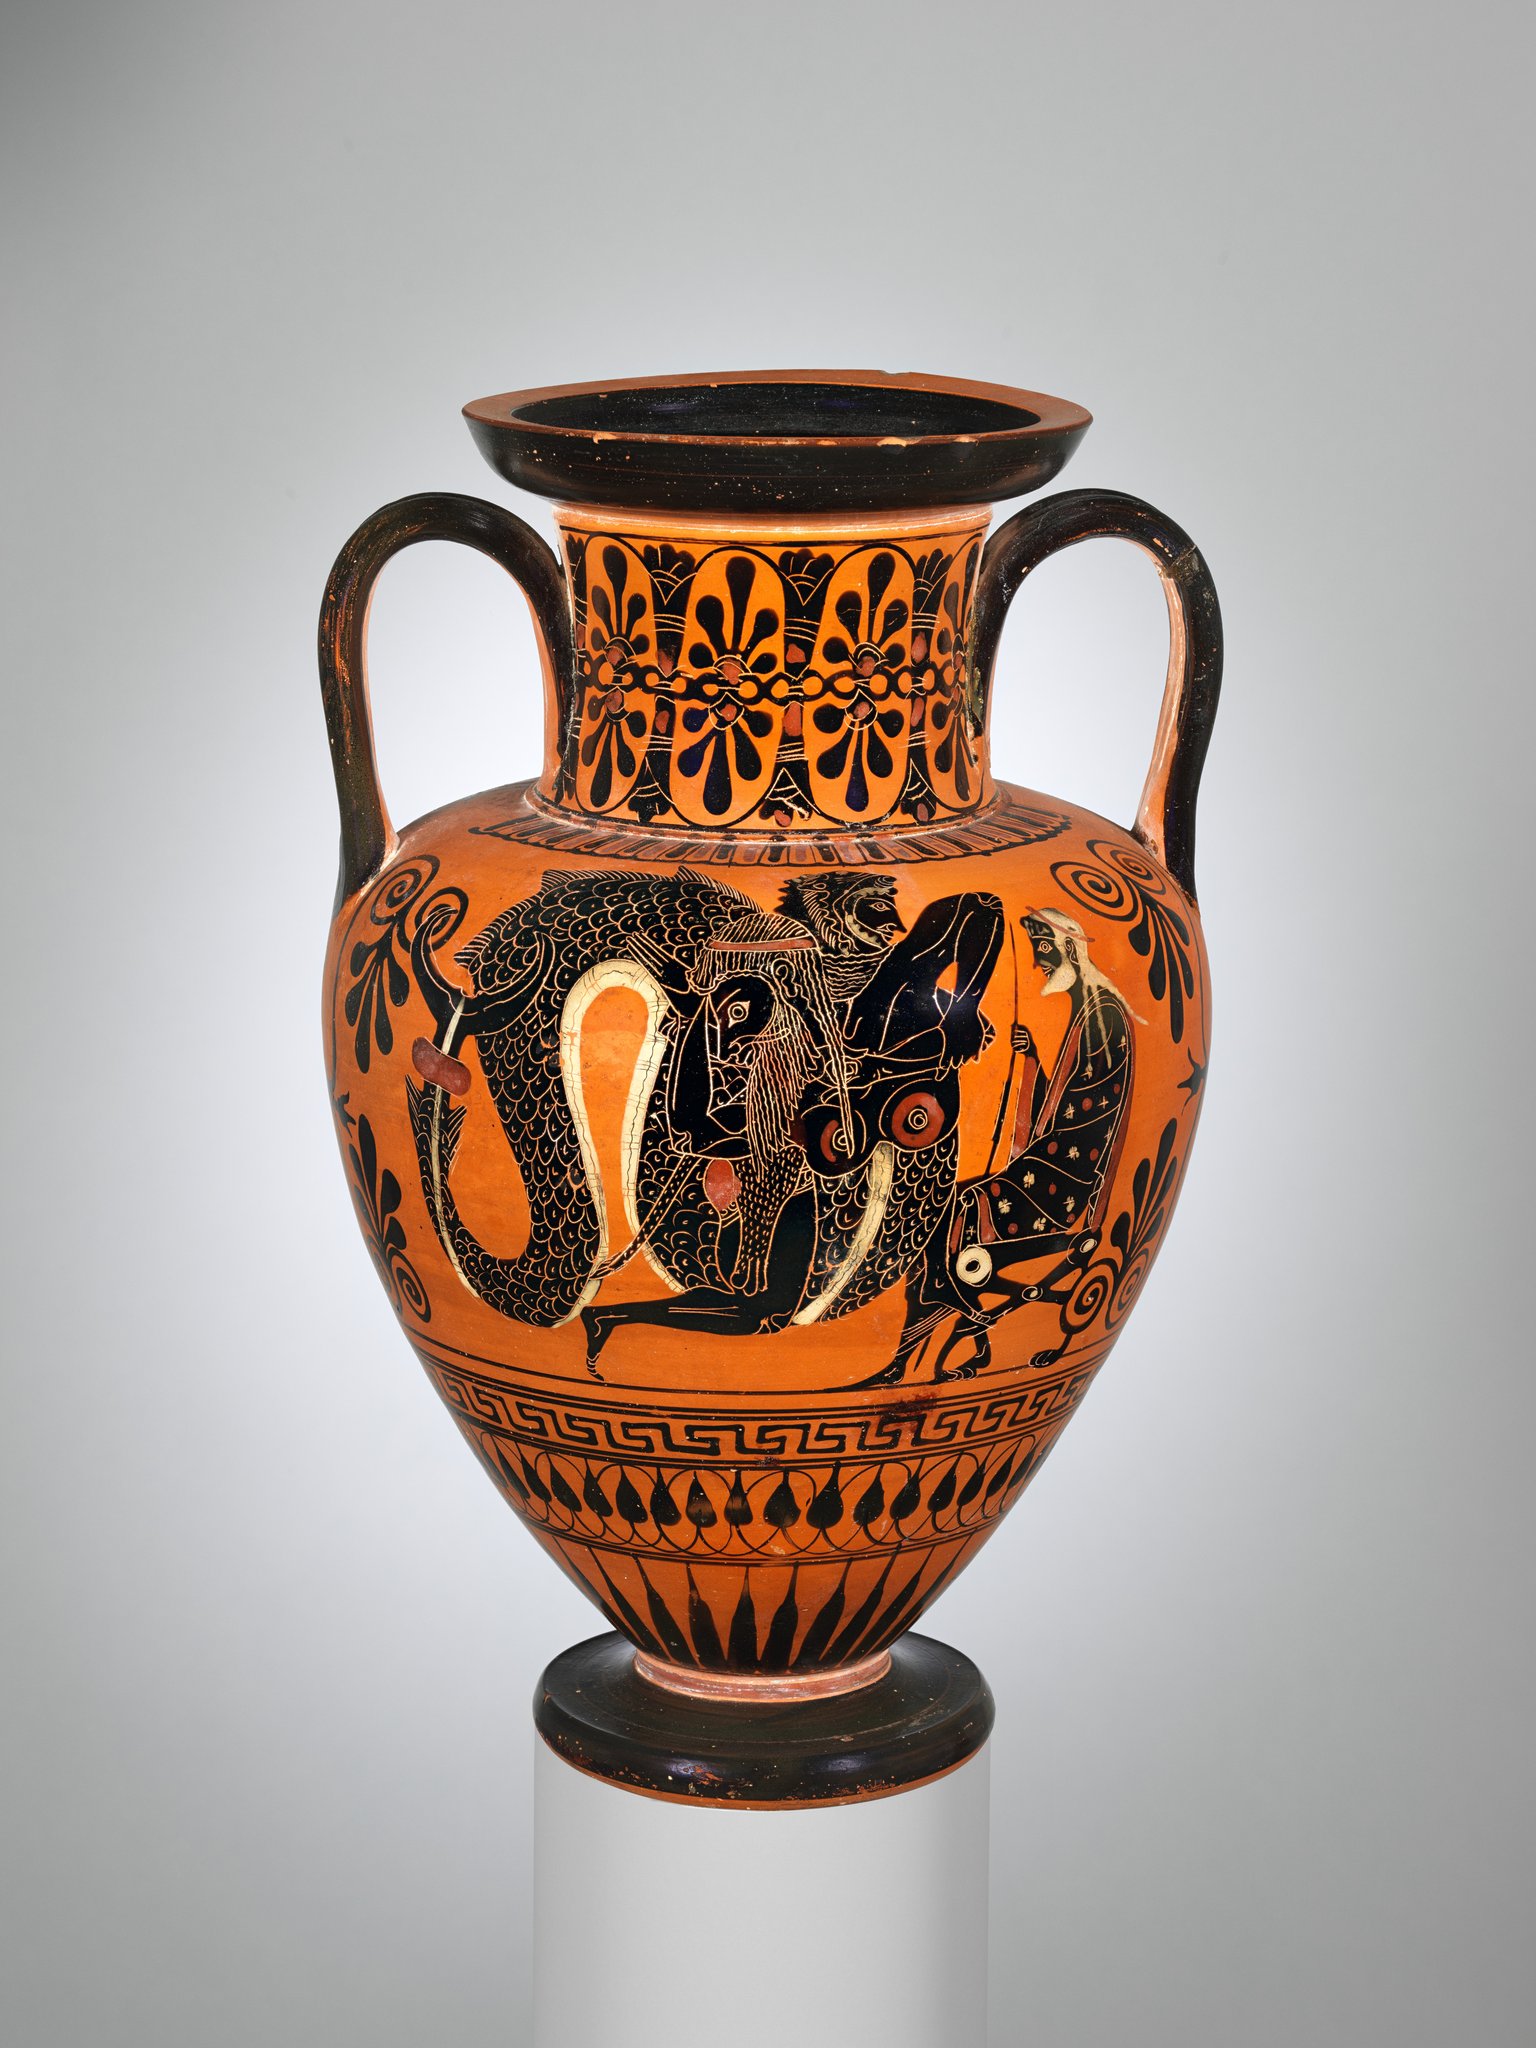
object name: neck amphora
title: Terracotta neck-amphora (jar)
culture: greek, attic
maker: medea group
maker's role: artist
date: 520 BCE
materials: terracotta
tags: men,women,triton,herakles